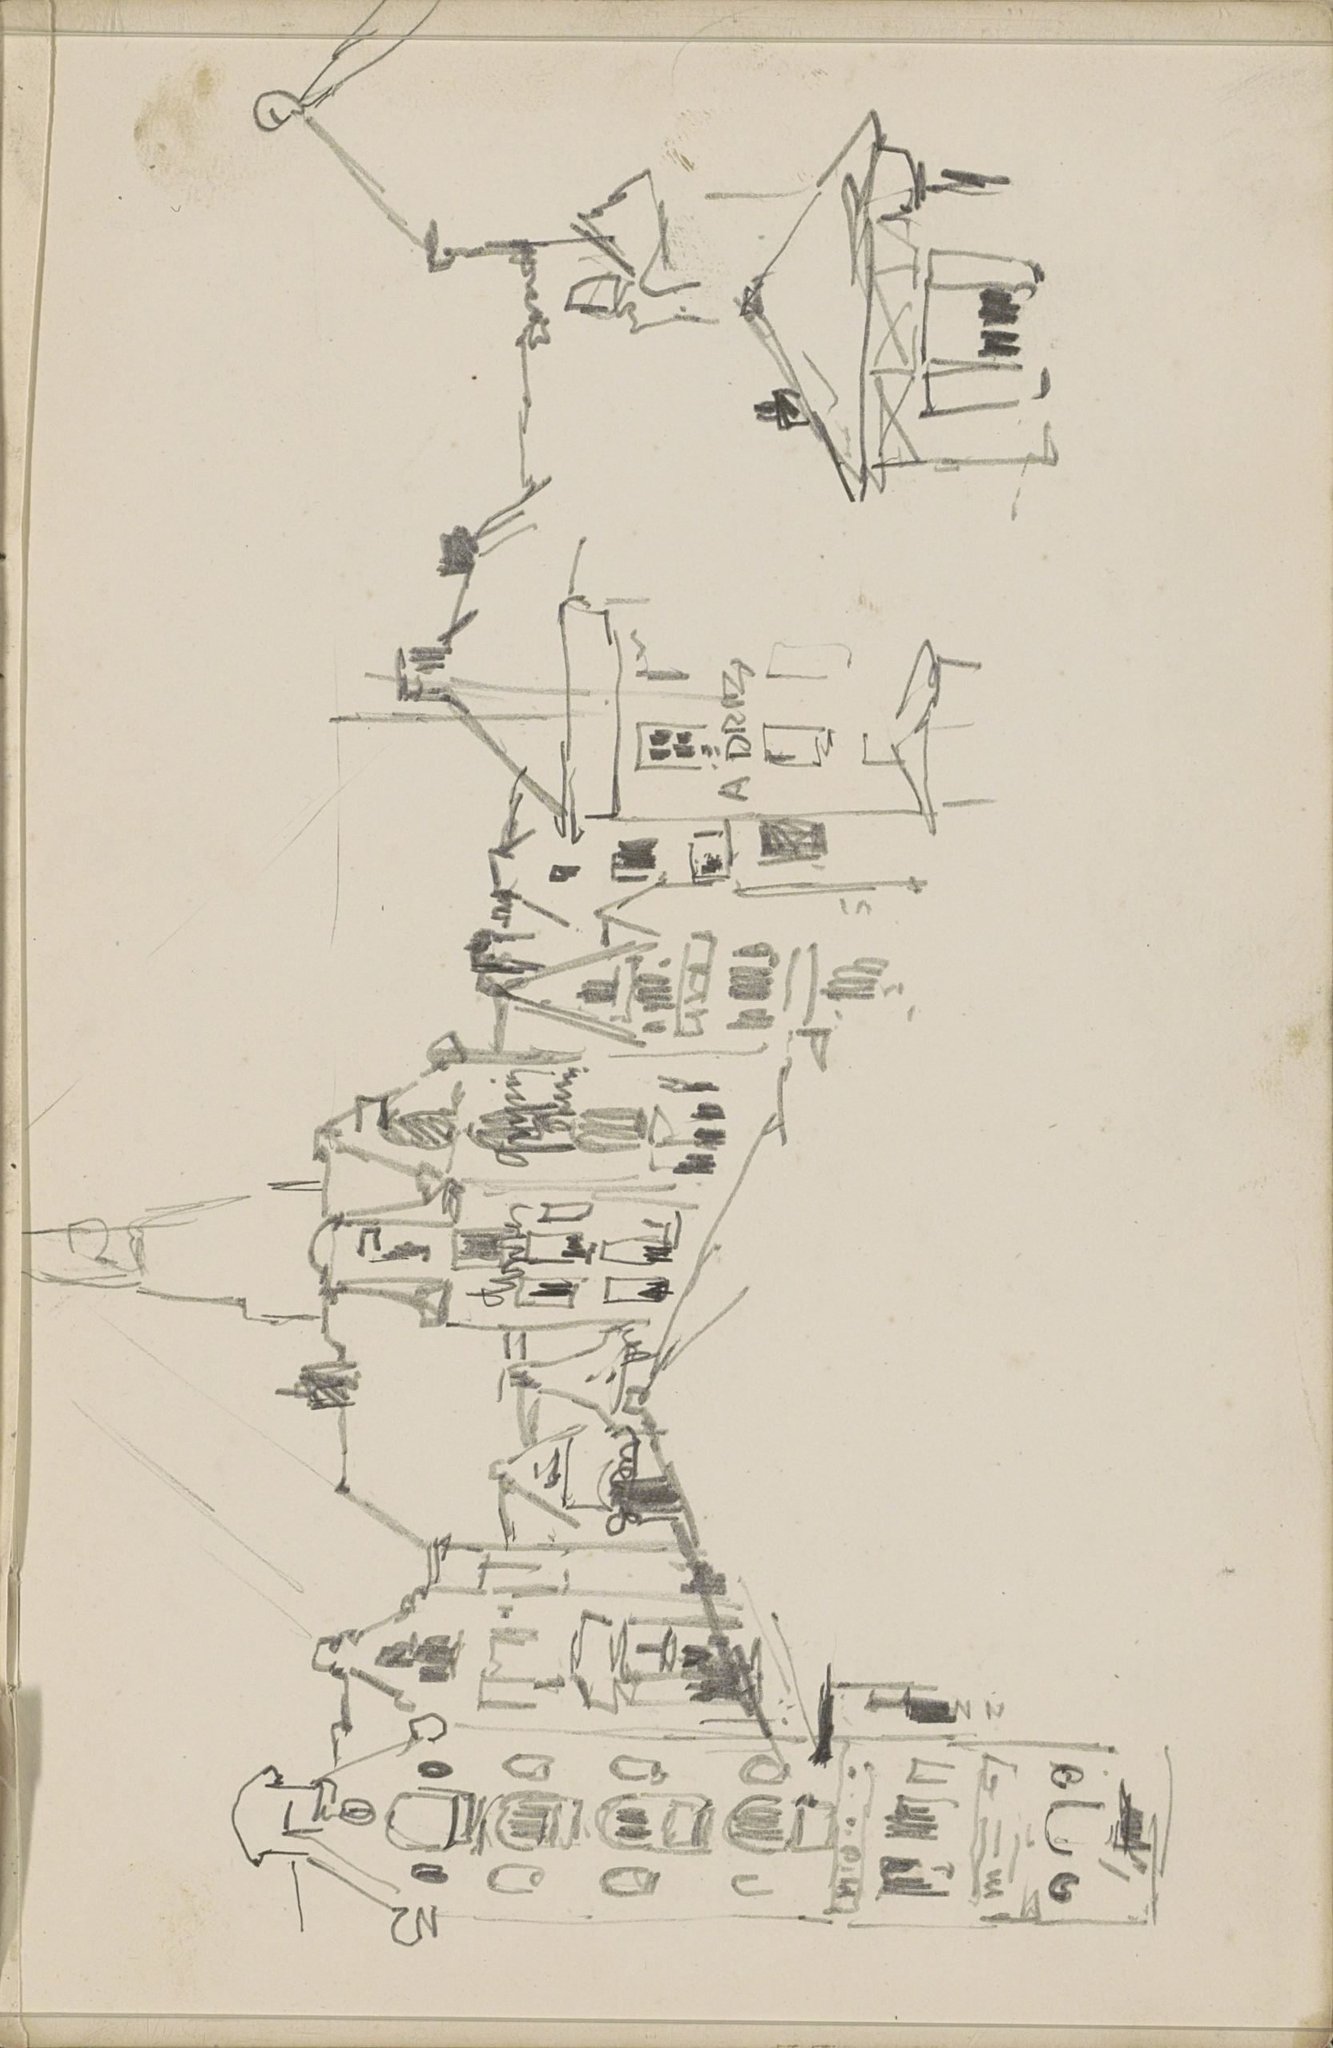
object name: sketchbook leaf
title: Achtergevels van de huizen aan de Warmoesstraat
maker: cornelis vreedenburgh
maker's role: draughtsman, print maker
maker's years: 1880-1946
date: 1890-1946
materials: paper, pencil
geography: amsterdam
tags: city-view, and landscape with man-made constructions, amsterdam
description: Blad 28 recto uit een schetsboek met 45 bladen.